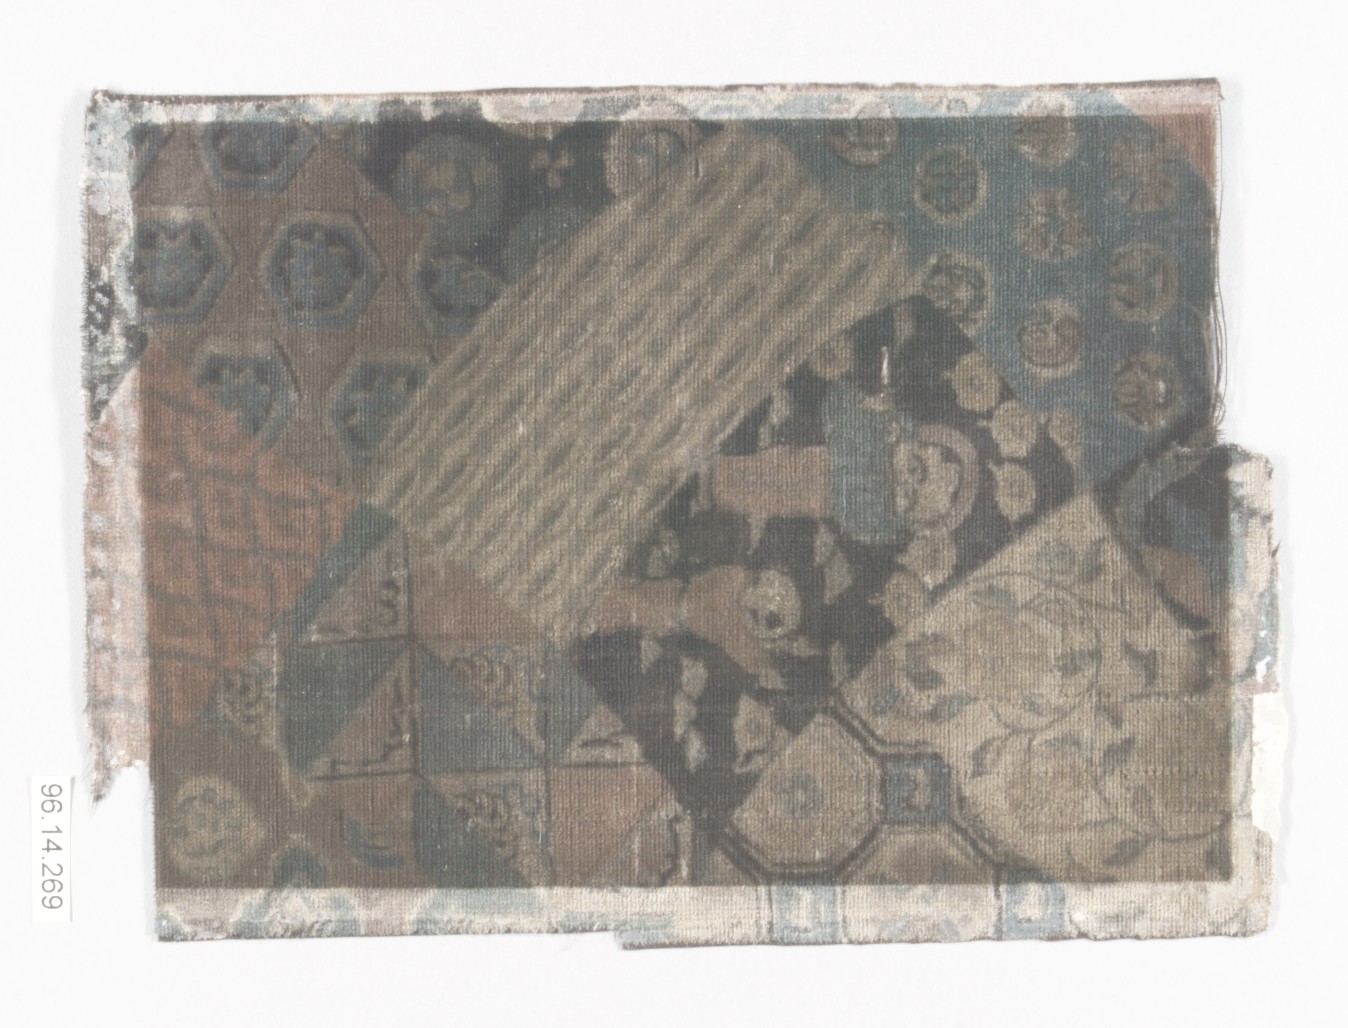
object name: piece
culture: japanese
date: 1701-1900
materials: silk